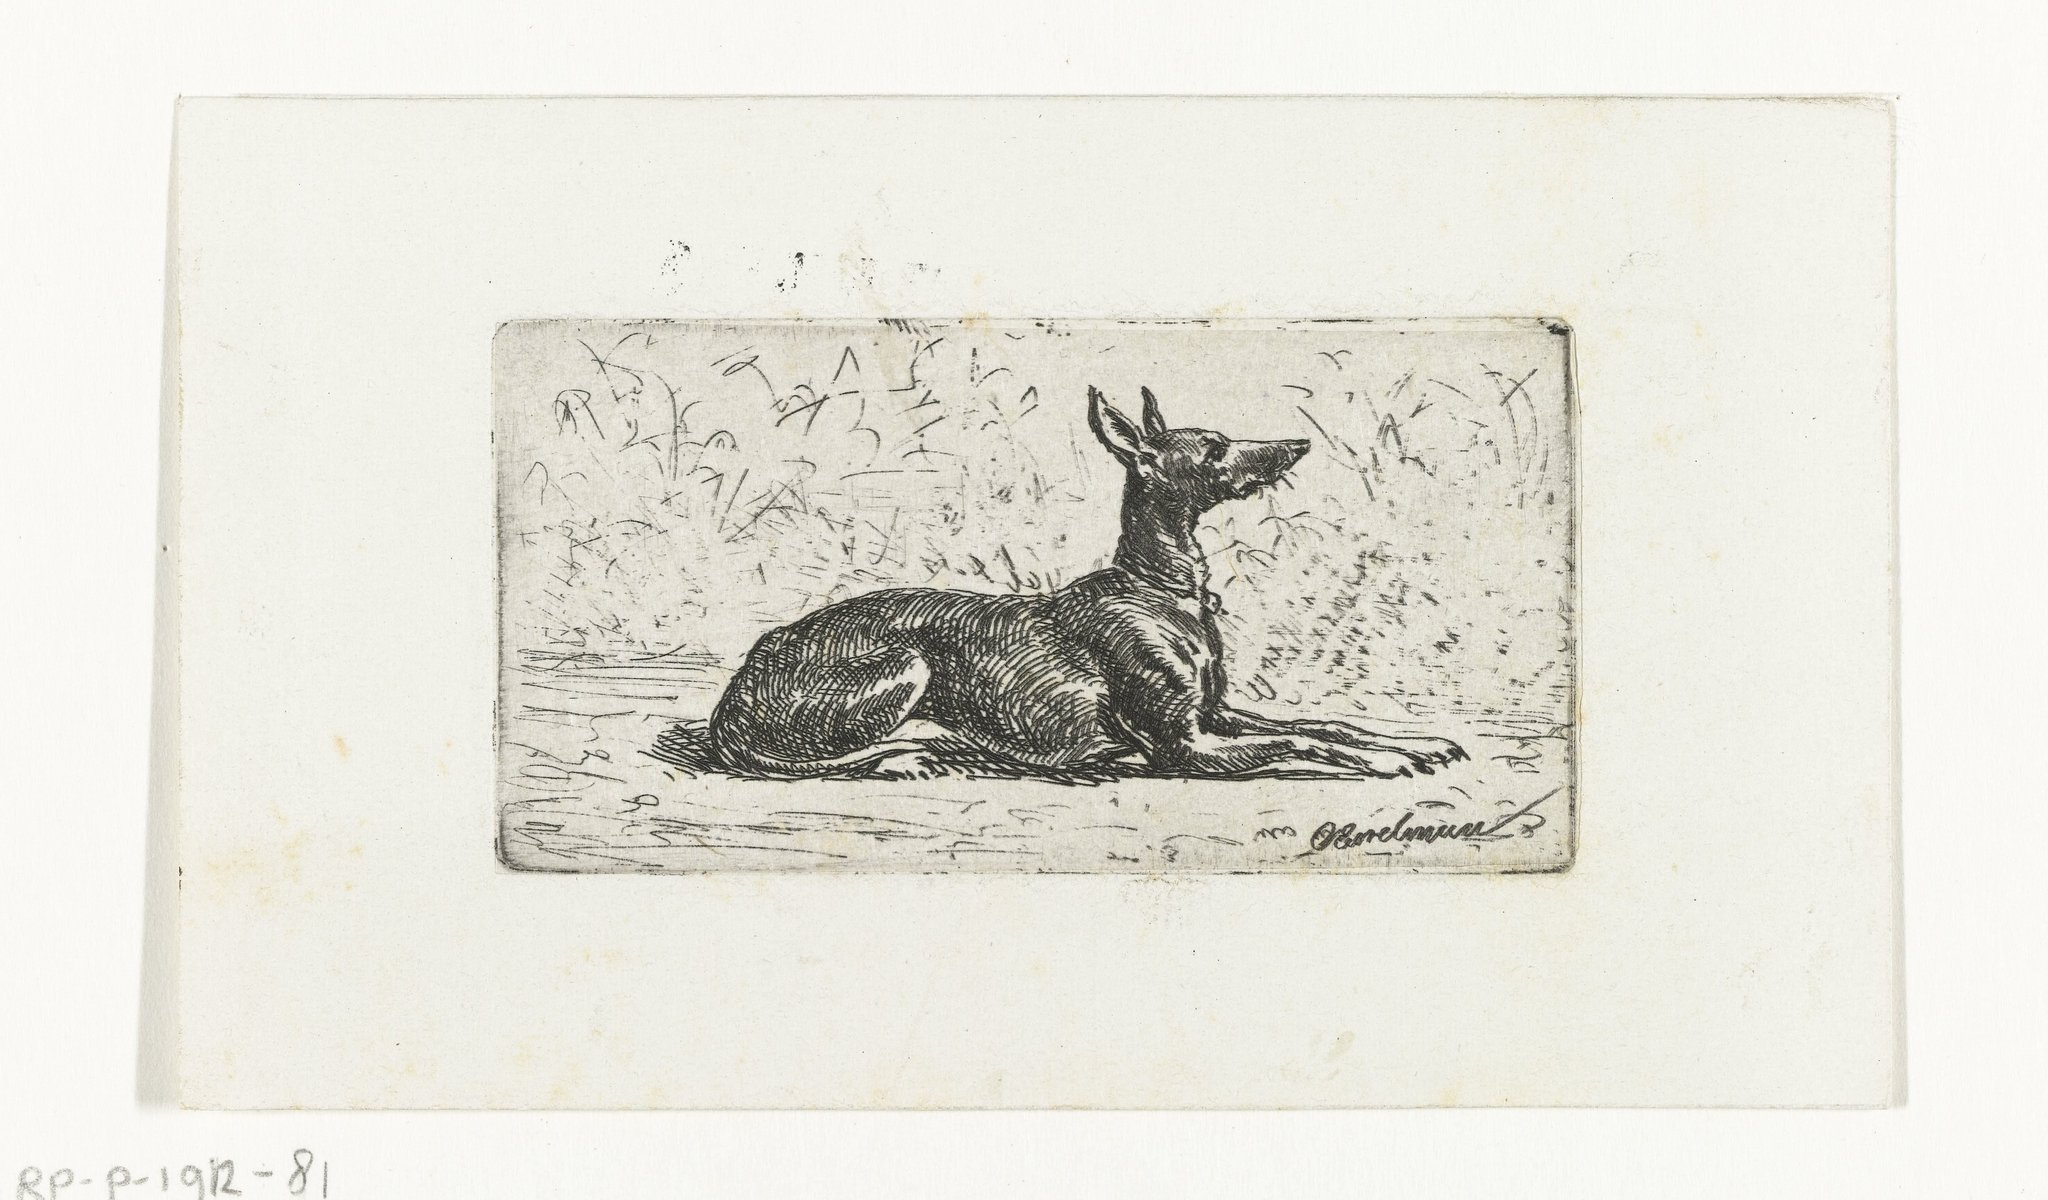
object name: print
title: Liggende hazewindhond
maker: otto eerelman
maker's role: draughtsman, painter, print maker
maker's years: 1839-1926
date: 1849-1912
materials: paper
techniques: etching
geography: netherlands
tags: dog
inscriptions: collector's mark: Lugt 2228